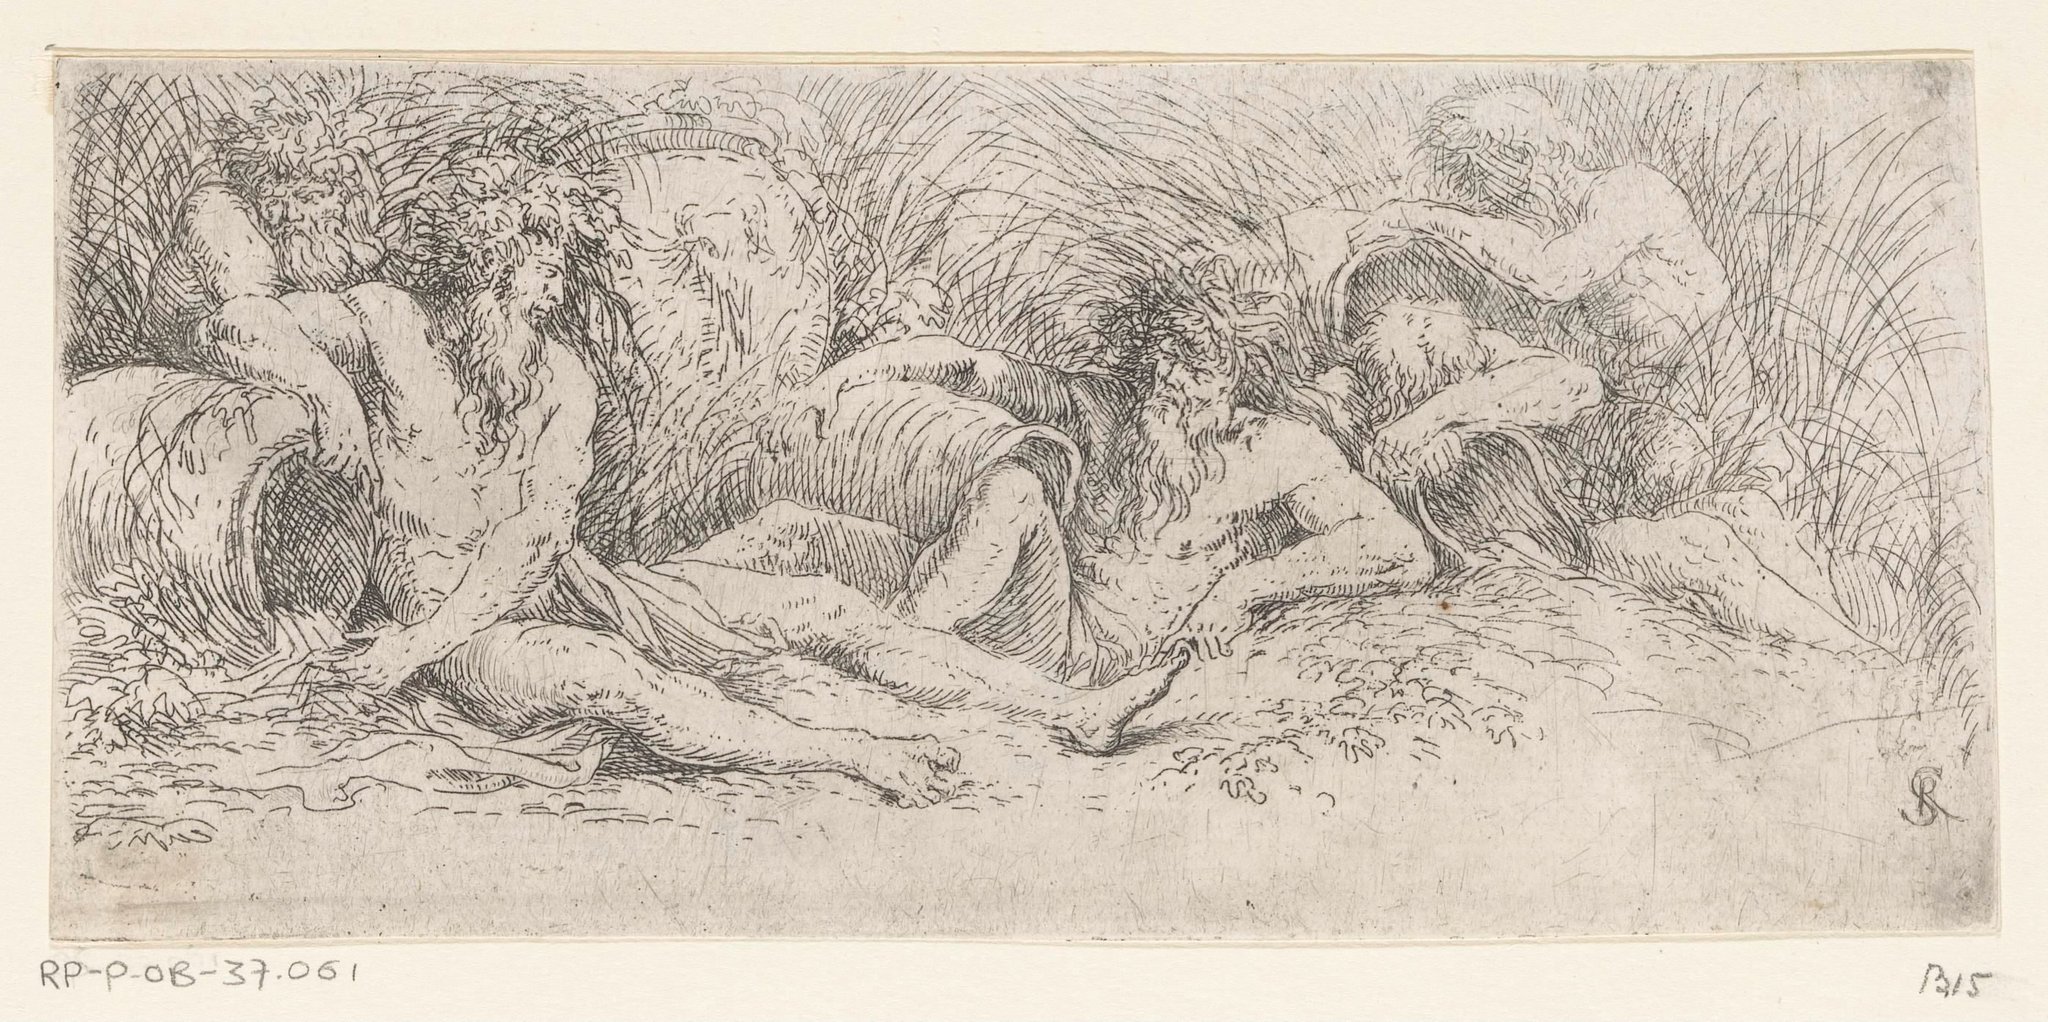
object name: print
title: Tritons en riviergoden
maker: salvator rosa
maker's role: draughtsman, painter, print maker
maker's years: 1615-1673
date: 1660-1661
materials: paper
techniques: drypoint, etching, intaglio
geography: italy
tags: river-gods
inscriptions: collector's mark: Lugt 240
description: Prent spiegelbeeldig naar een tekening die zich eens bevond in de collectie van Ladislao Odescalchi te Rome. De tekening werd in 1974 geveild te Berlijn.